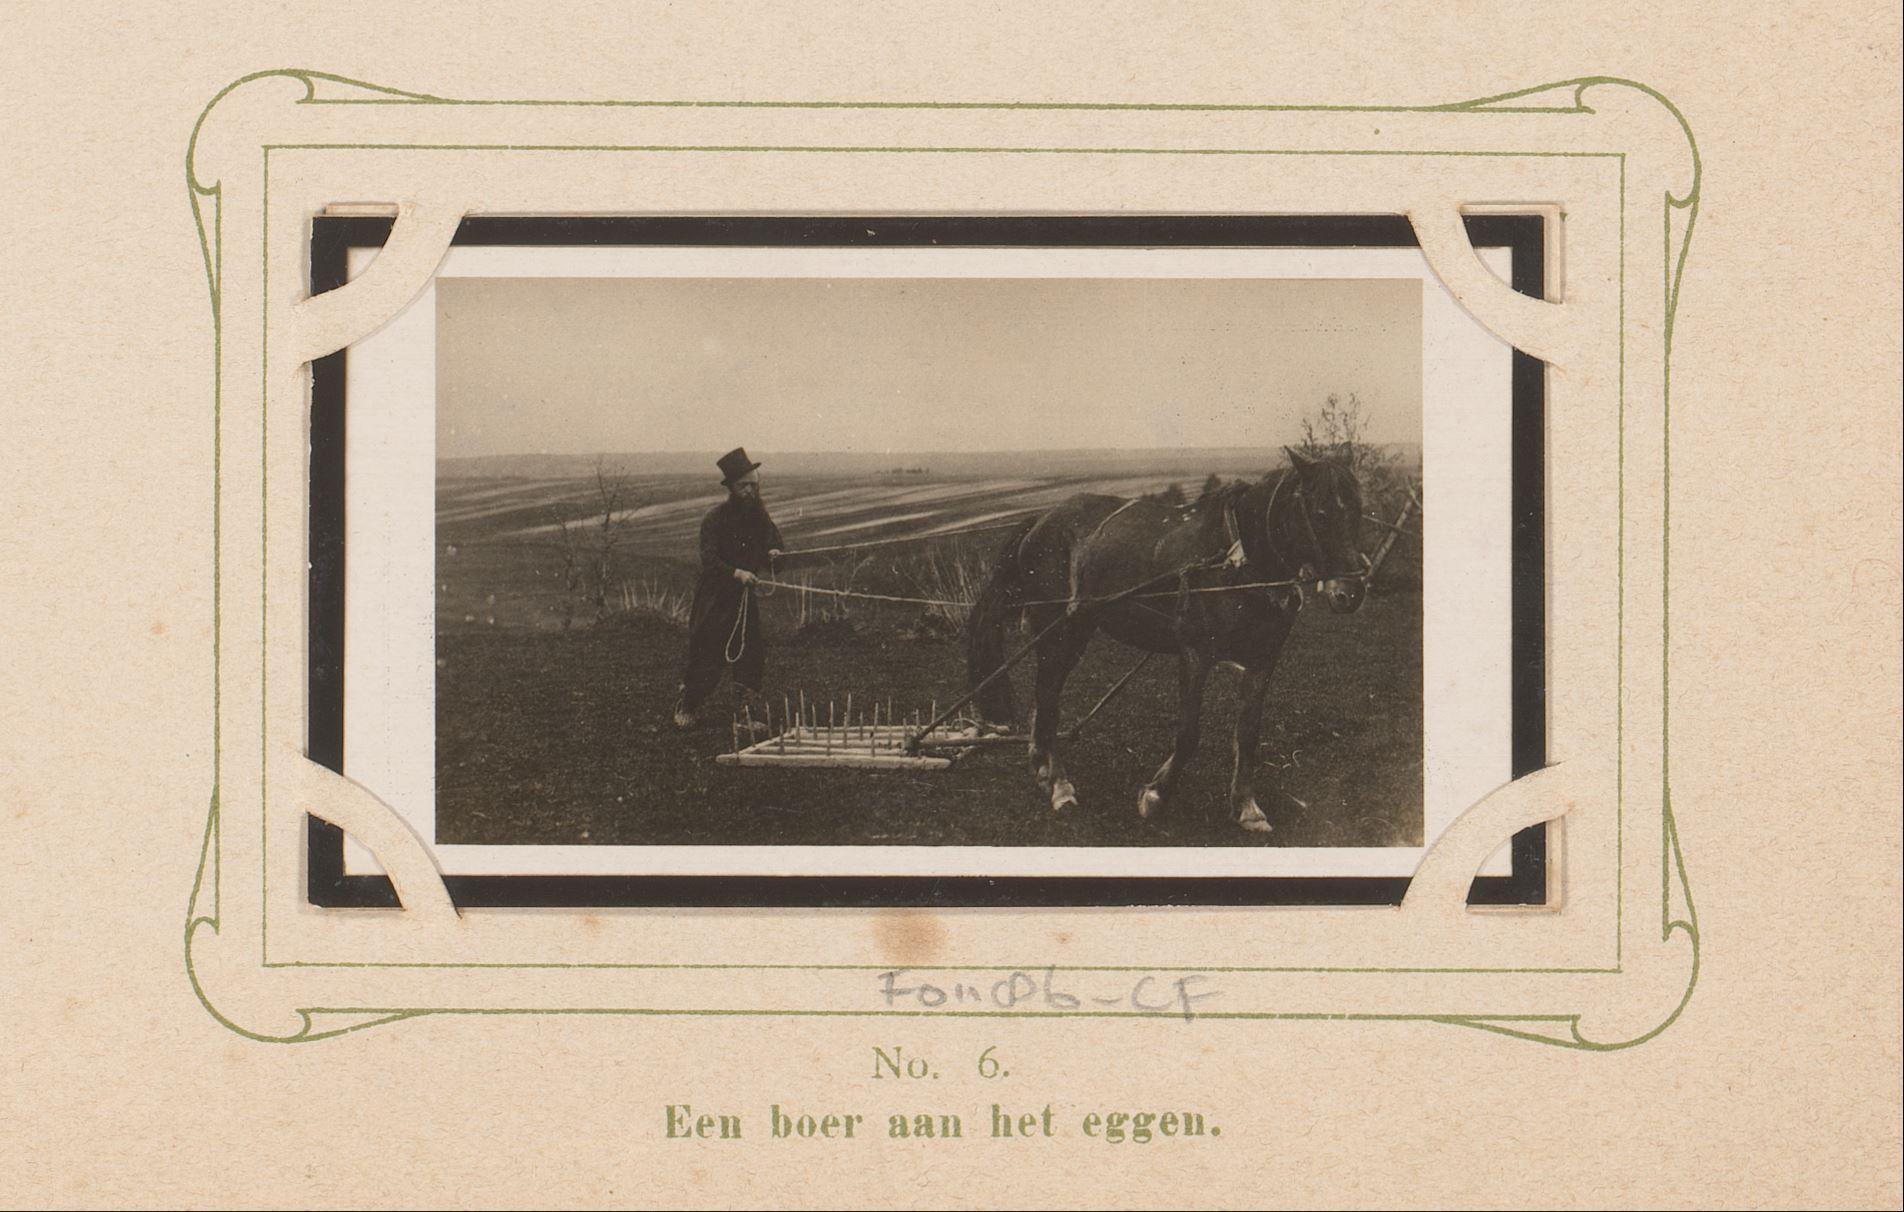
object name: album leaf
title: Boer ploegt het land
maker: Anonymous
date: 1904-1905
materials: photographic support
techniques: gelatin silver print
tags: farmers, ploughing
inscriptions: inscription: ‘No. 6./ Eenboer aan het eggen.’